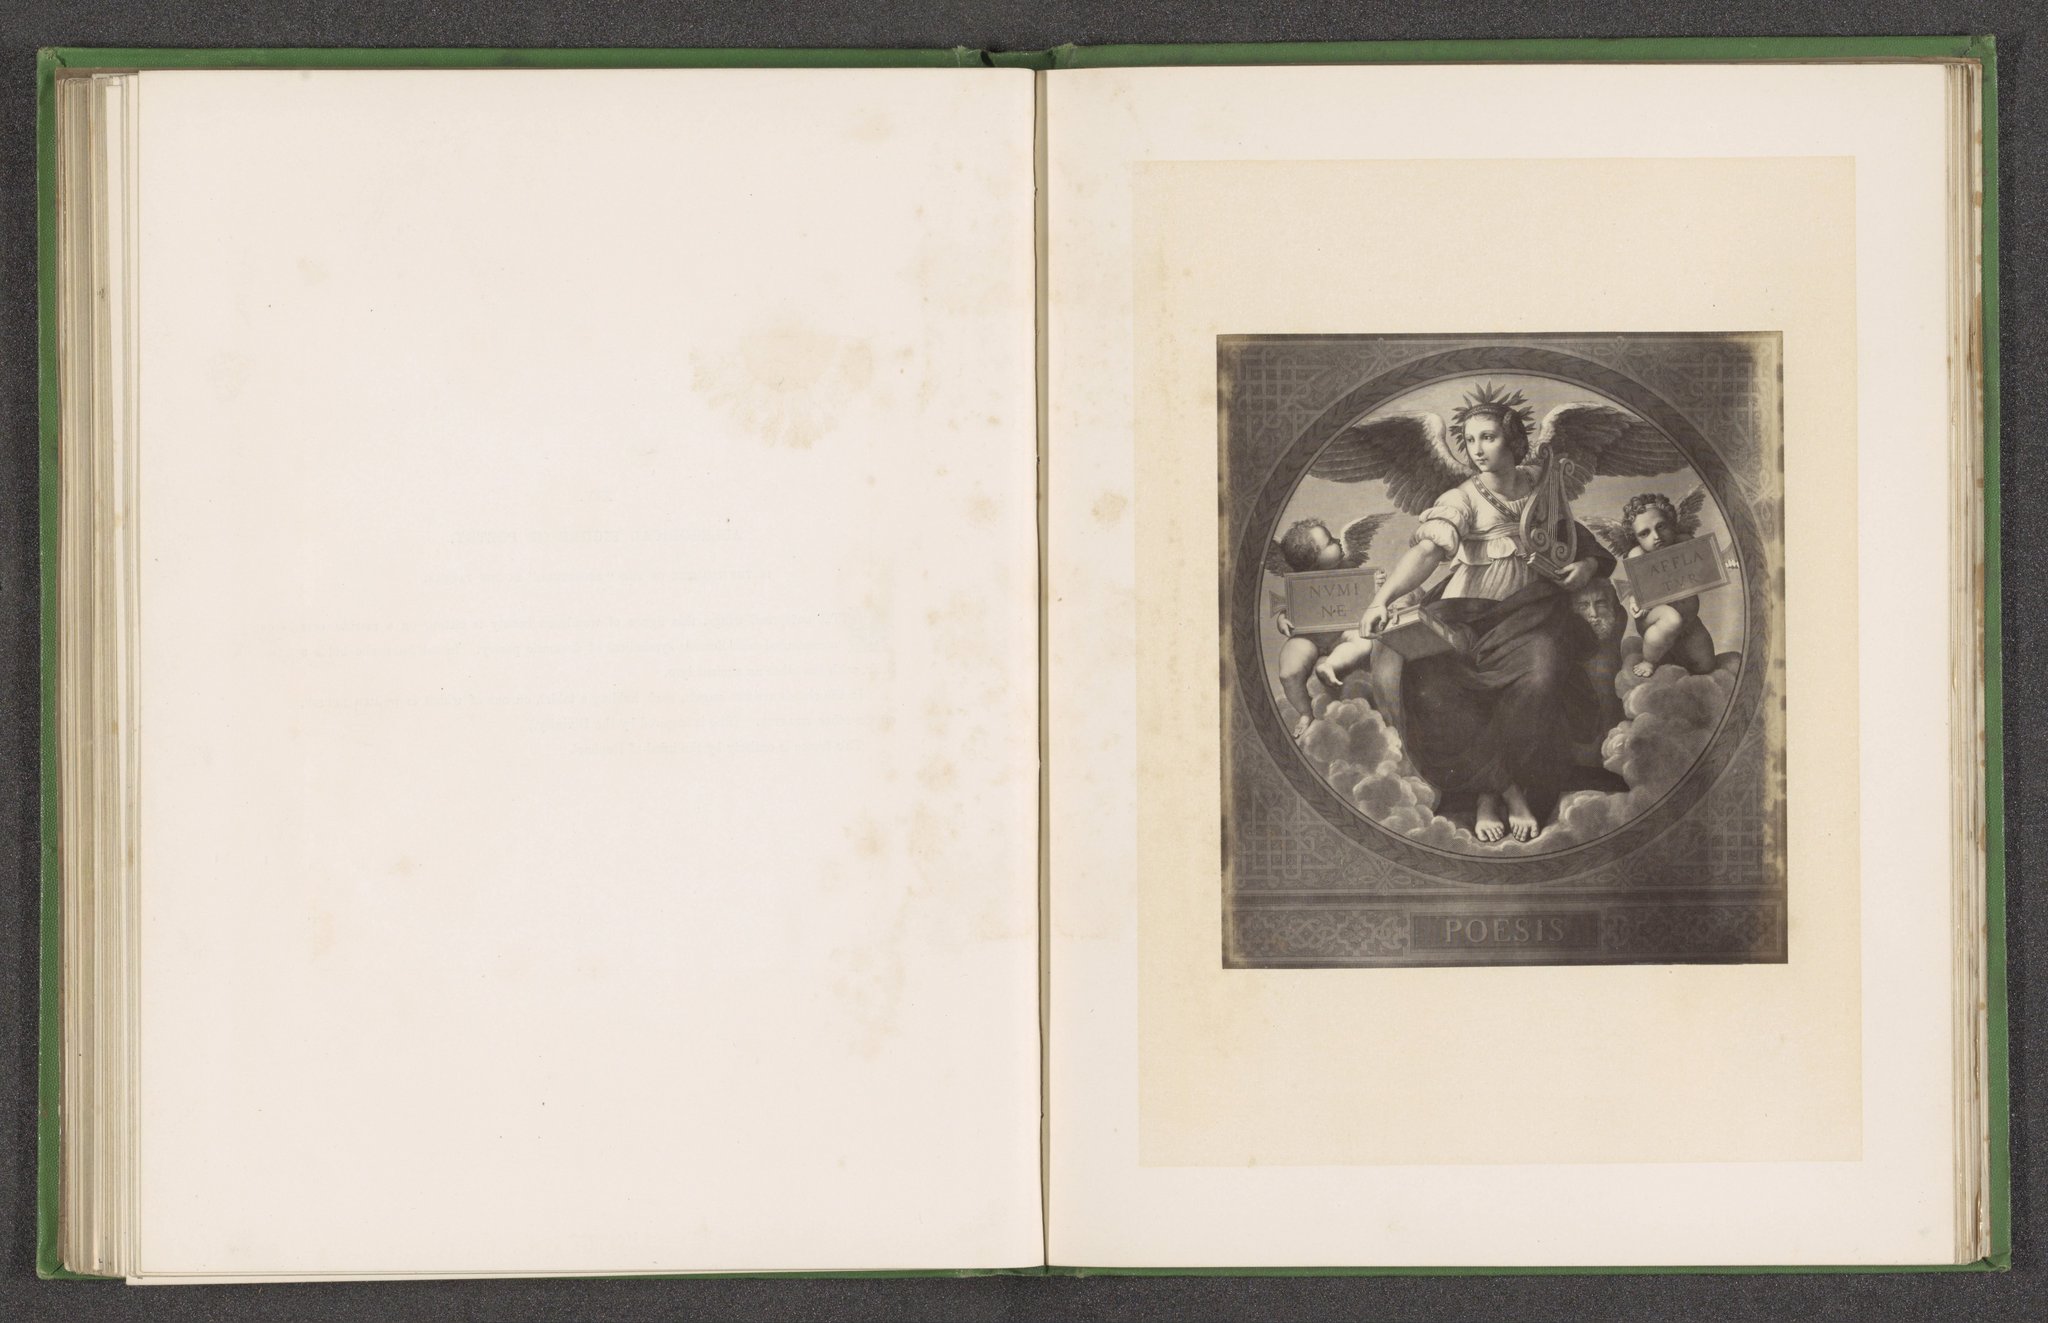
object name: page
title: Fotoreproductie van een prent van de allegorie van de poëzie in de Stanza della Segnatura door Rafaël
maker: joseph cundall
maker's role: fotograaf, schrijver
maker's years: 1818-1895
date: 1859-1869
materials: photographic support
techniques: albumen print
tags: symbolic representations, allegories and emblems ~ poetry; 'poesia' (ripa)